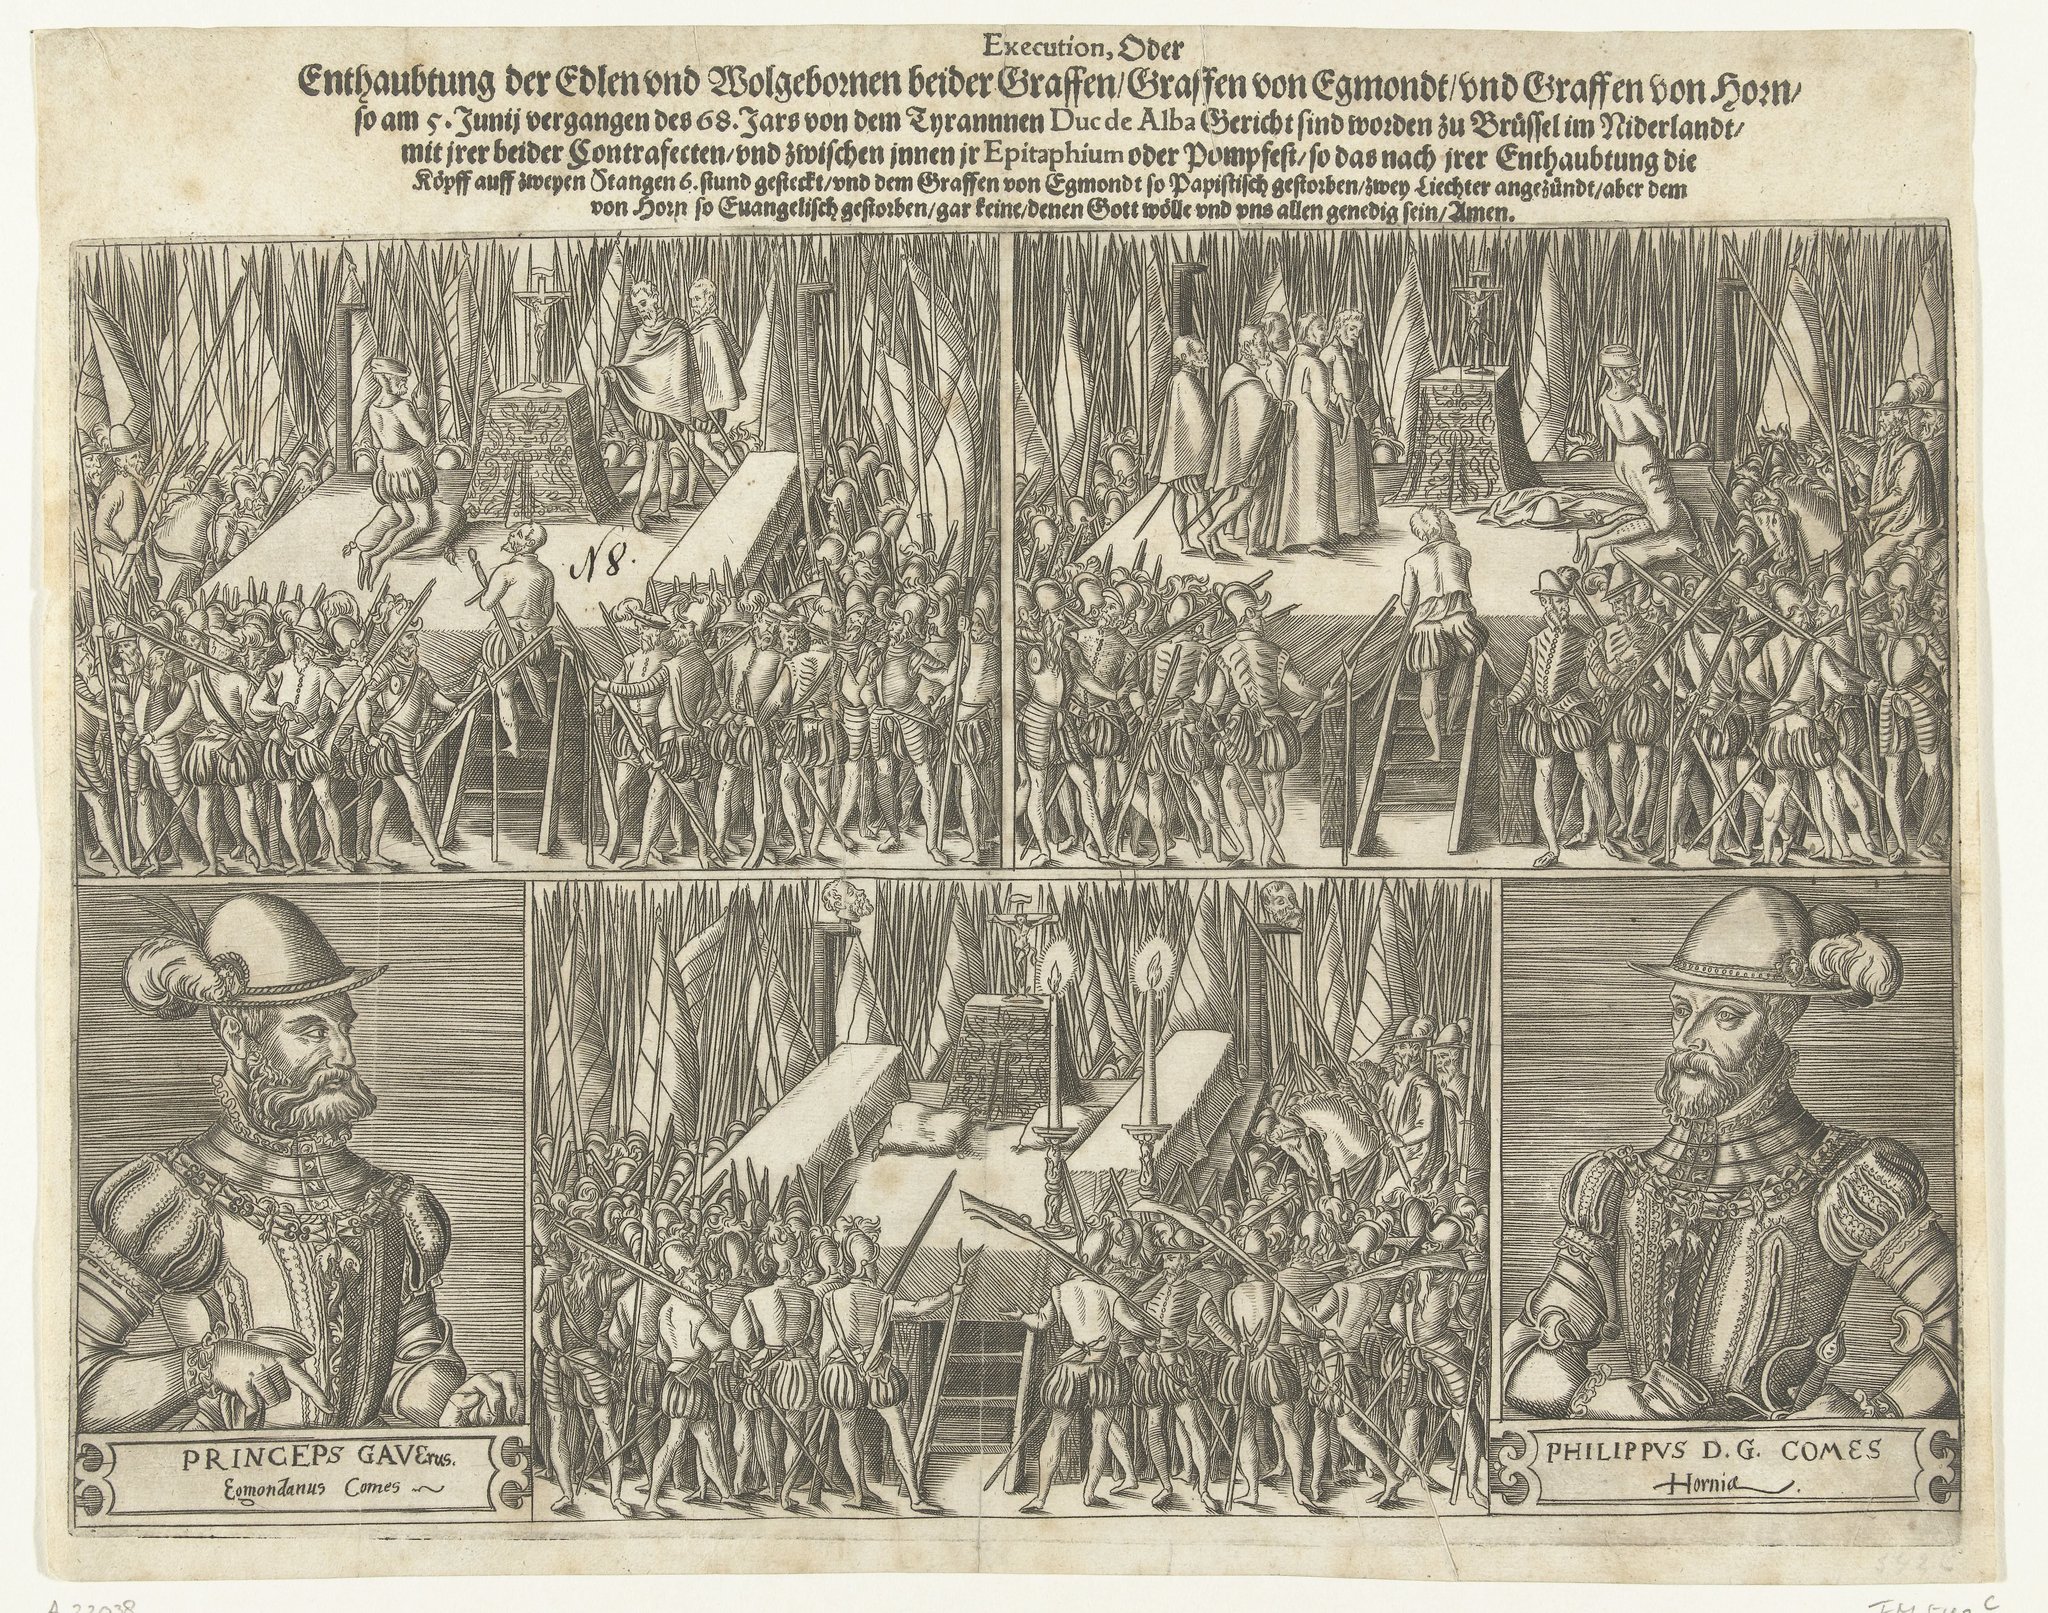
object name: print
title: The Beheading of Egmont and Horne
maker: wolfgang meyerpeck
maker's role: print maker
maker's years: -1595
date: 1568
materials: paper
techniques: engraving, letterpress printing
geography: leipzig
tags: fernando álvarez de toledo (3rd duke of alba), brussels, on the scaffold or place of execution, violent death by beheading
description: The counts of Egmont and of Horne are among the most important nobles in the Netherlands. Immediately following Alva’s arrival they are imprisoned and accused of high treason, lese-majesty, and supporting the Protestants.Their execution takes place on 5 June 1568 in Brussels’ Grand-Place. News of their beheading travels beyond the Netherlands via prints and is met with great revulsion.